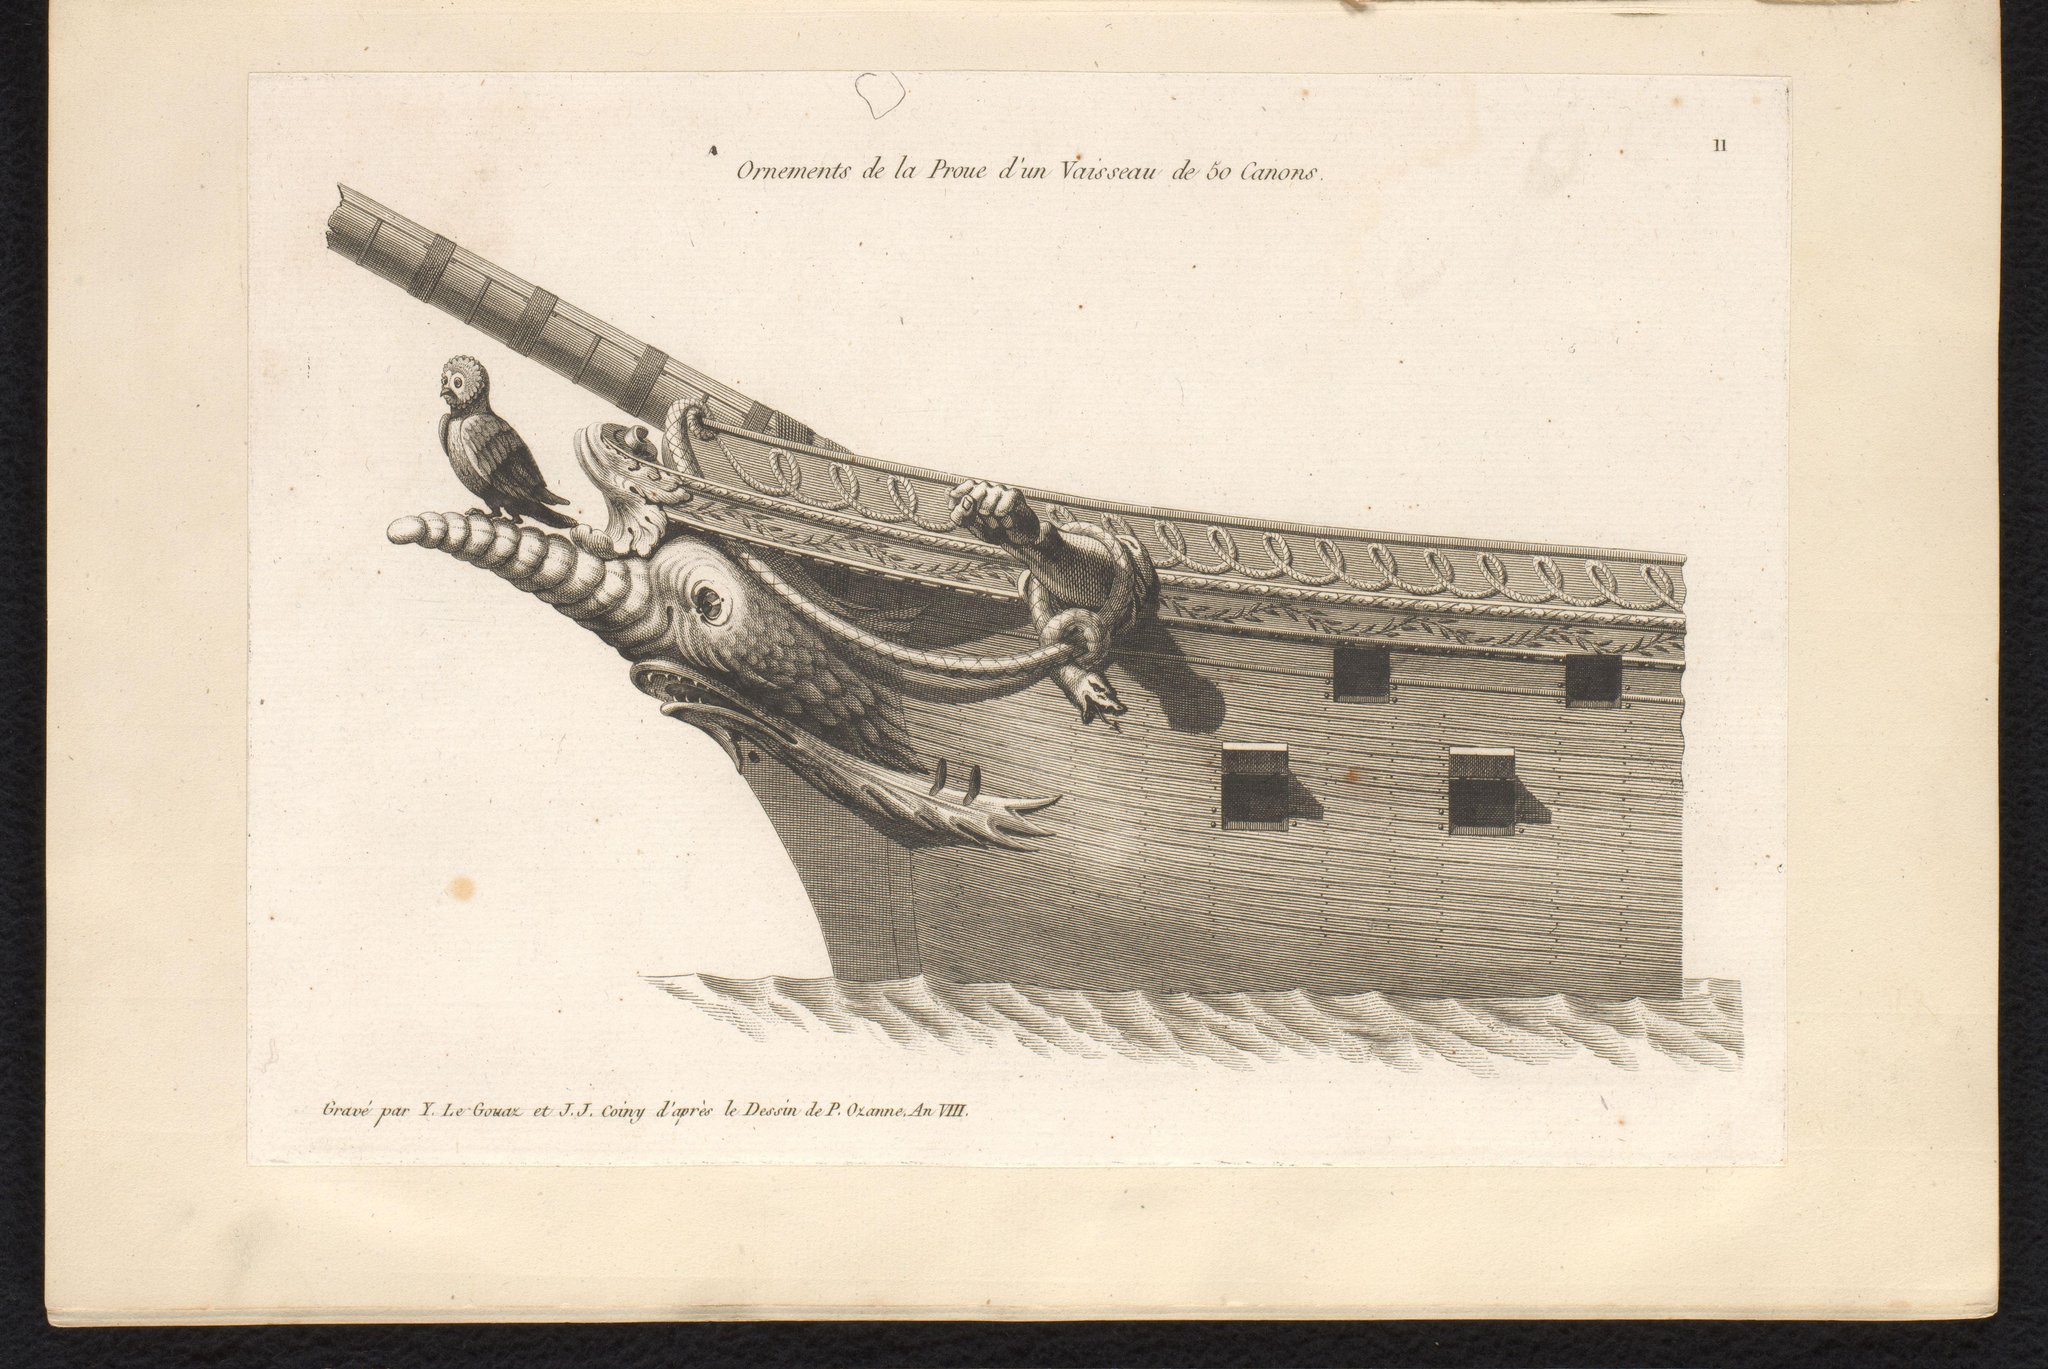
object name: album leaf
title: Ornements de la proue de différents vaisseaux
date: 1799-1800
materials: paper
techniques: engraving, etching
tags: sailing-ship, sailing-boat, parts of ship's exterior: bow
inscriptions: collector's mark: Lugt 2228, collector's mark: Lugt 2760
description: Deze prent maakt deel uit van een album.